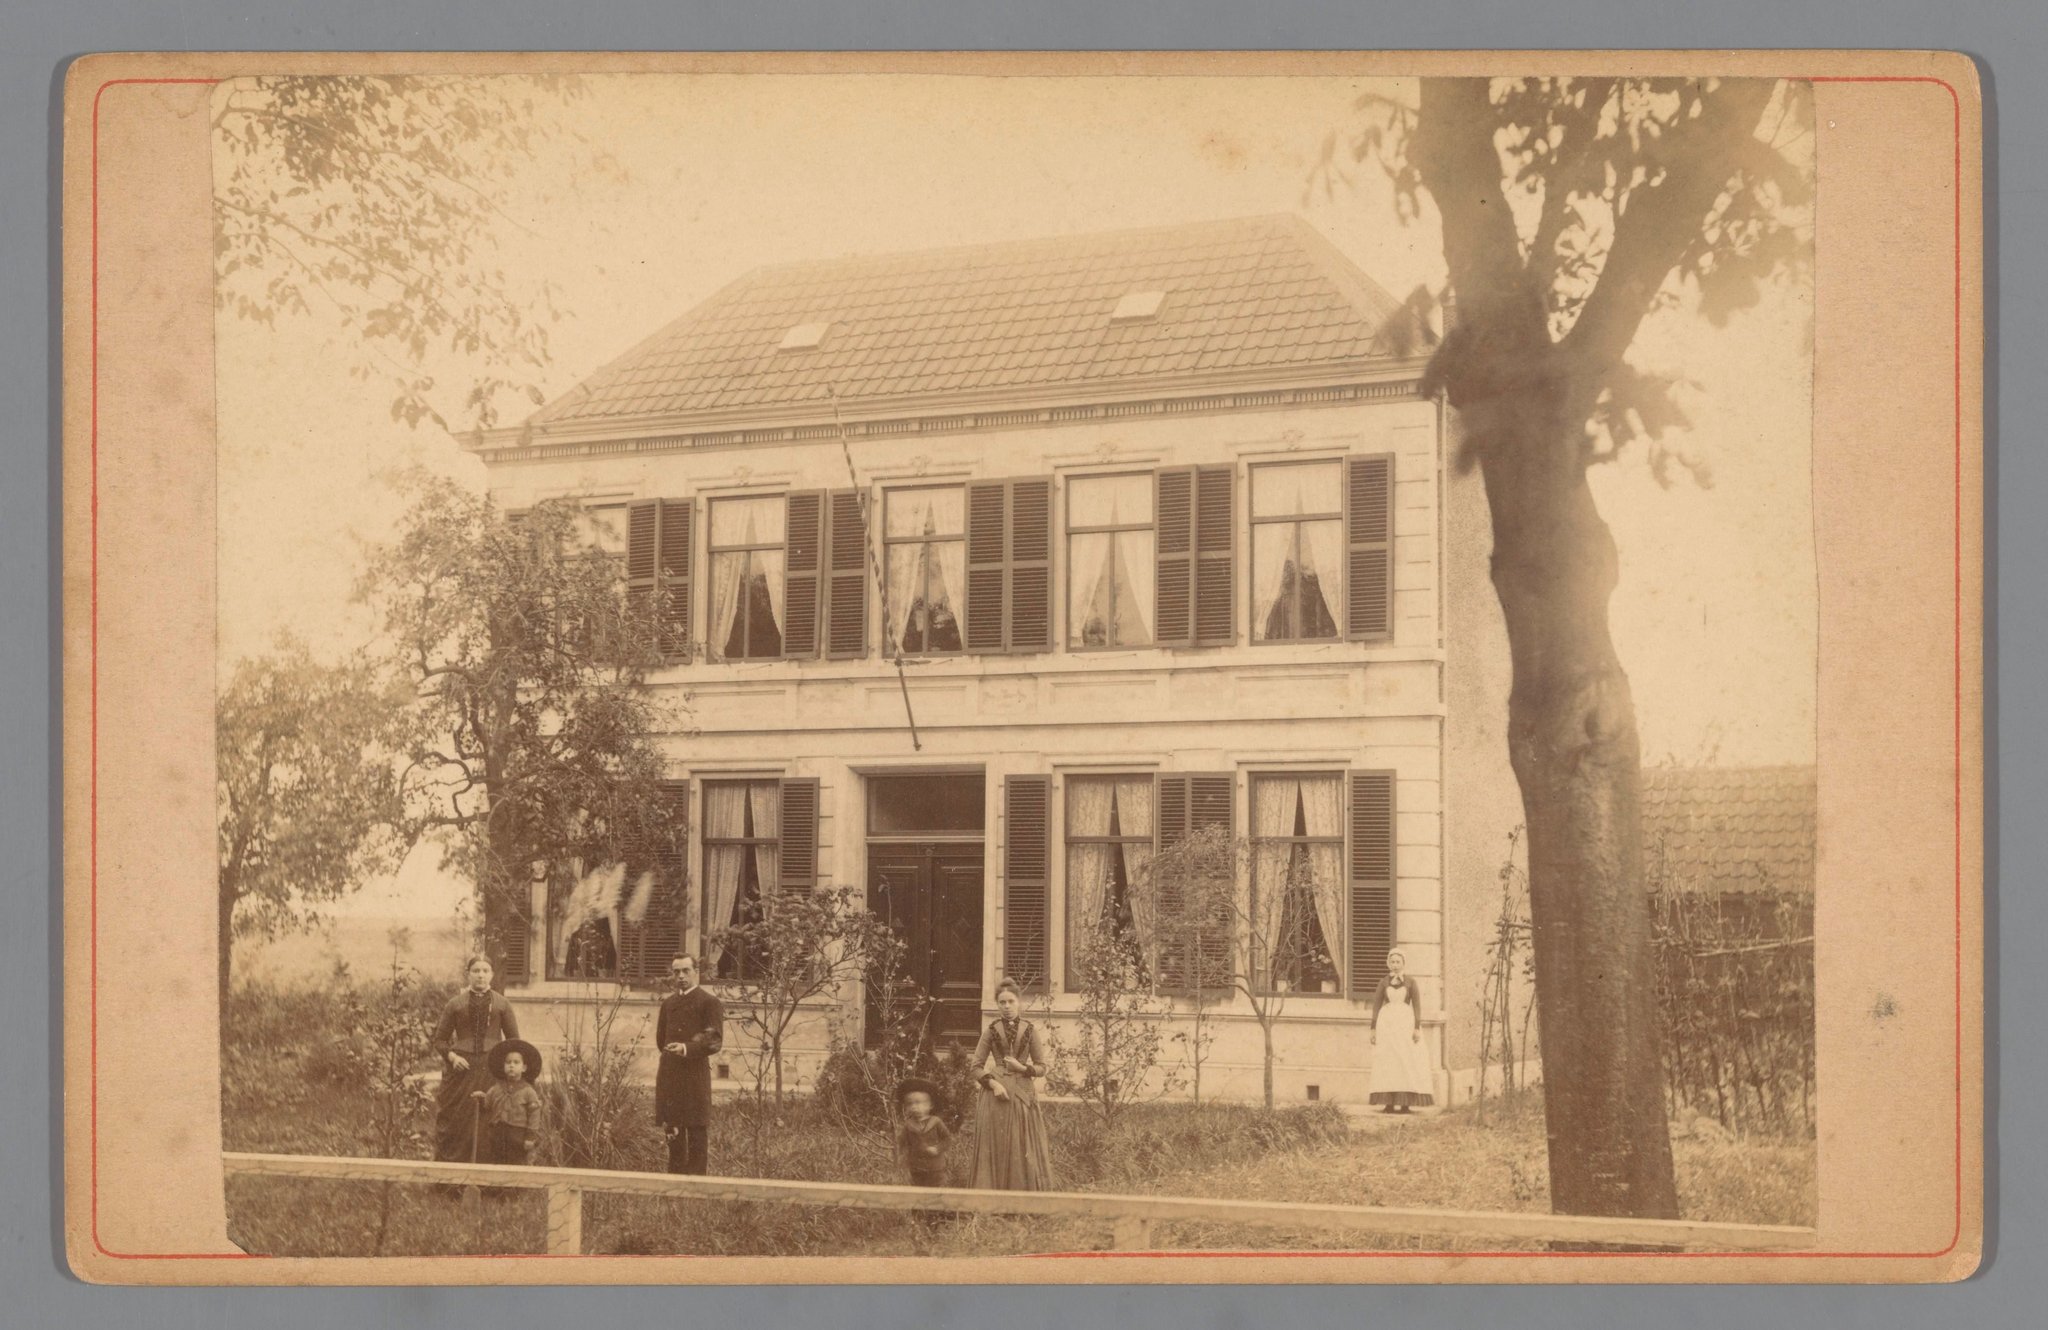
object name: cabinet photograph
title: Gezin in de voortuin van een buitenhuis in Nederland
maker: Anonymous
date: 1850-1900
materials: cardboard, photographic support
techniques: albumen print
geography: netherlands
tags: parents with their children, villa